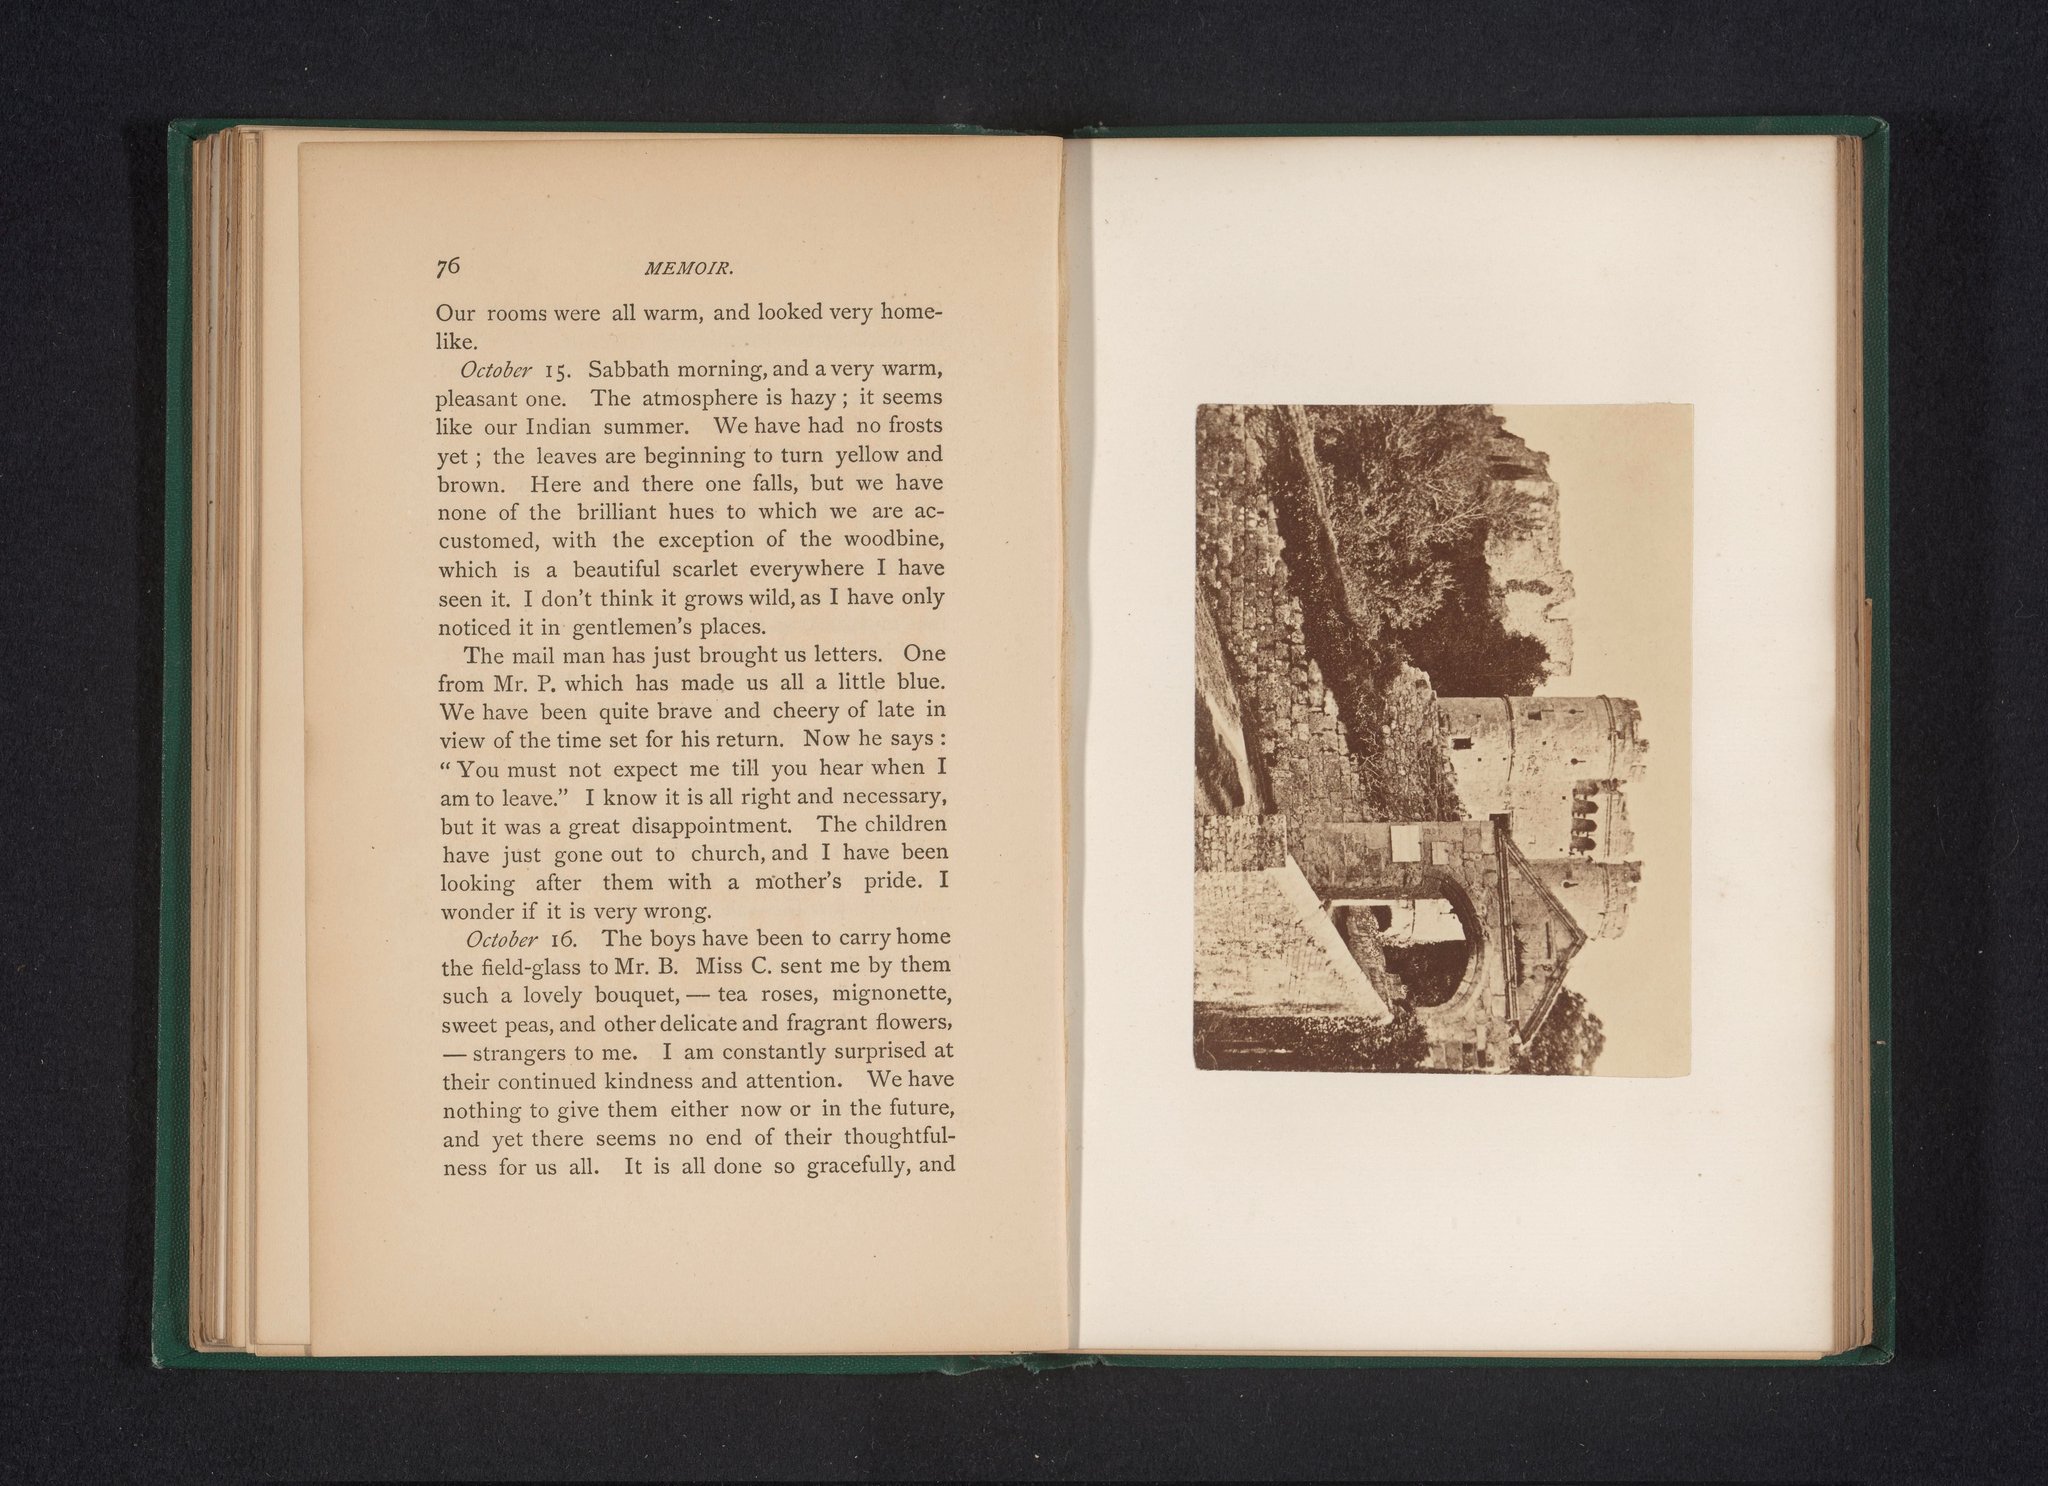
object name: photograph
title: Gezicht op Carisbrooke Castle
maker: Anonymous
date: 1868-1873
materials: photographic support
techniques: albumen print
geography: carisbrooke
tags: castle, façade (of house or building)